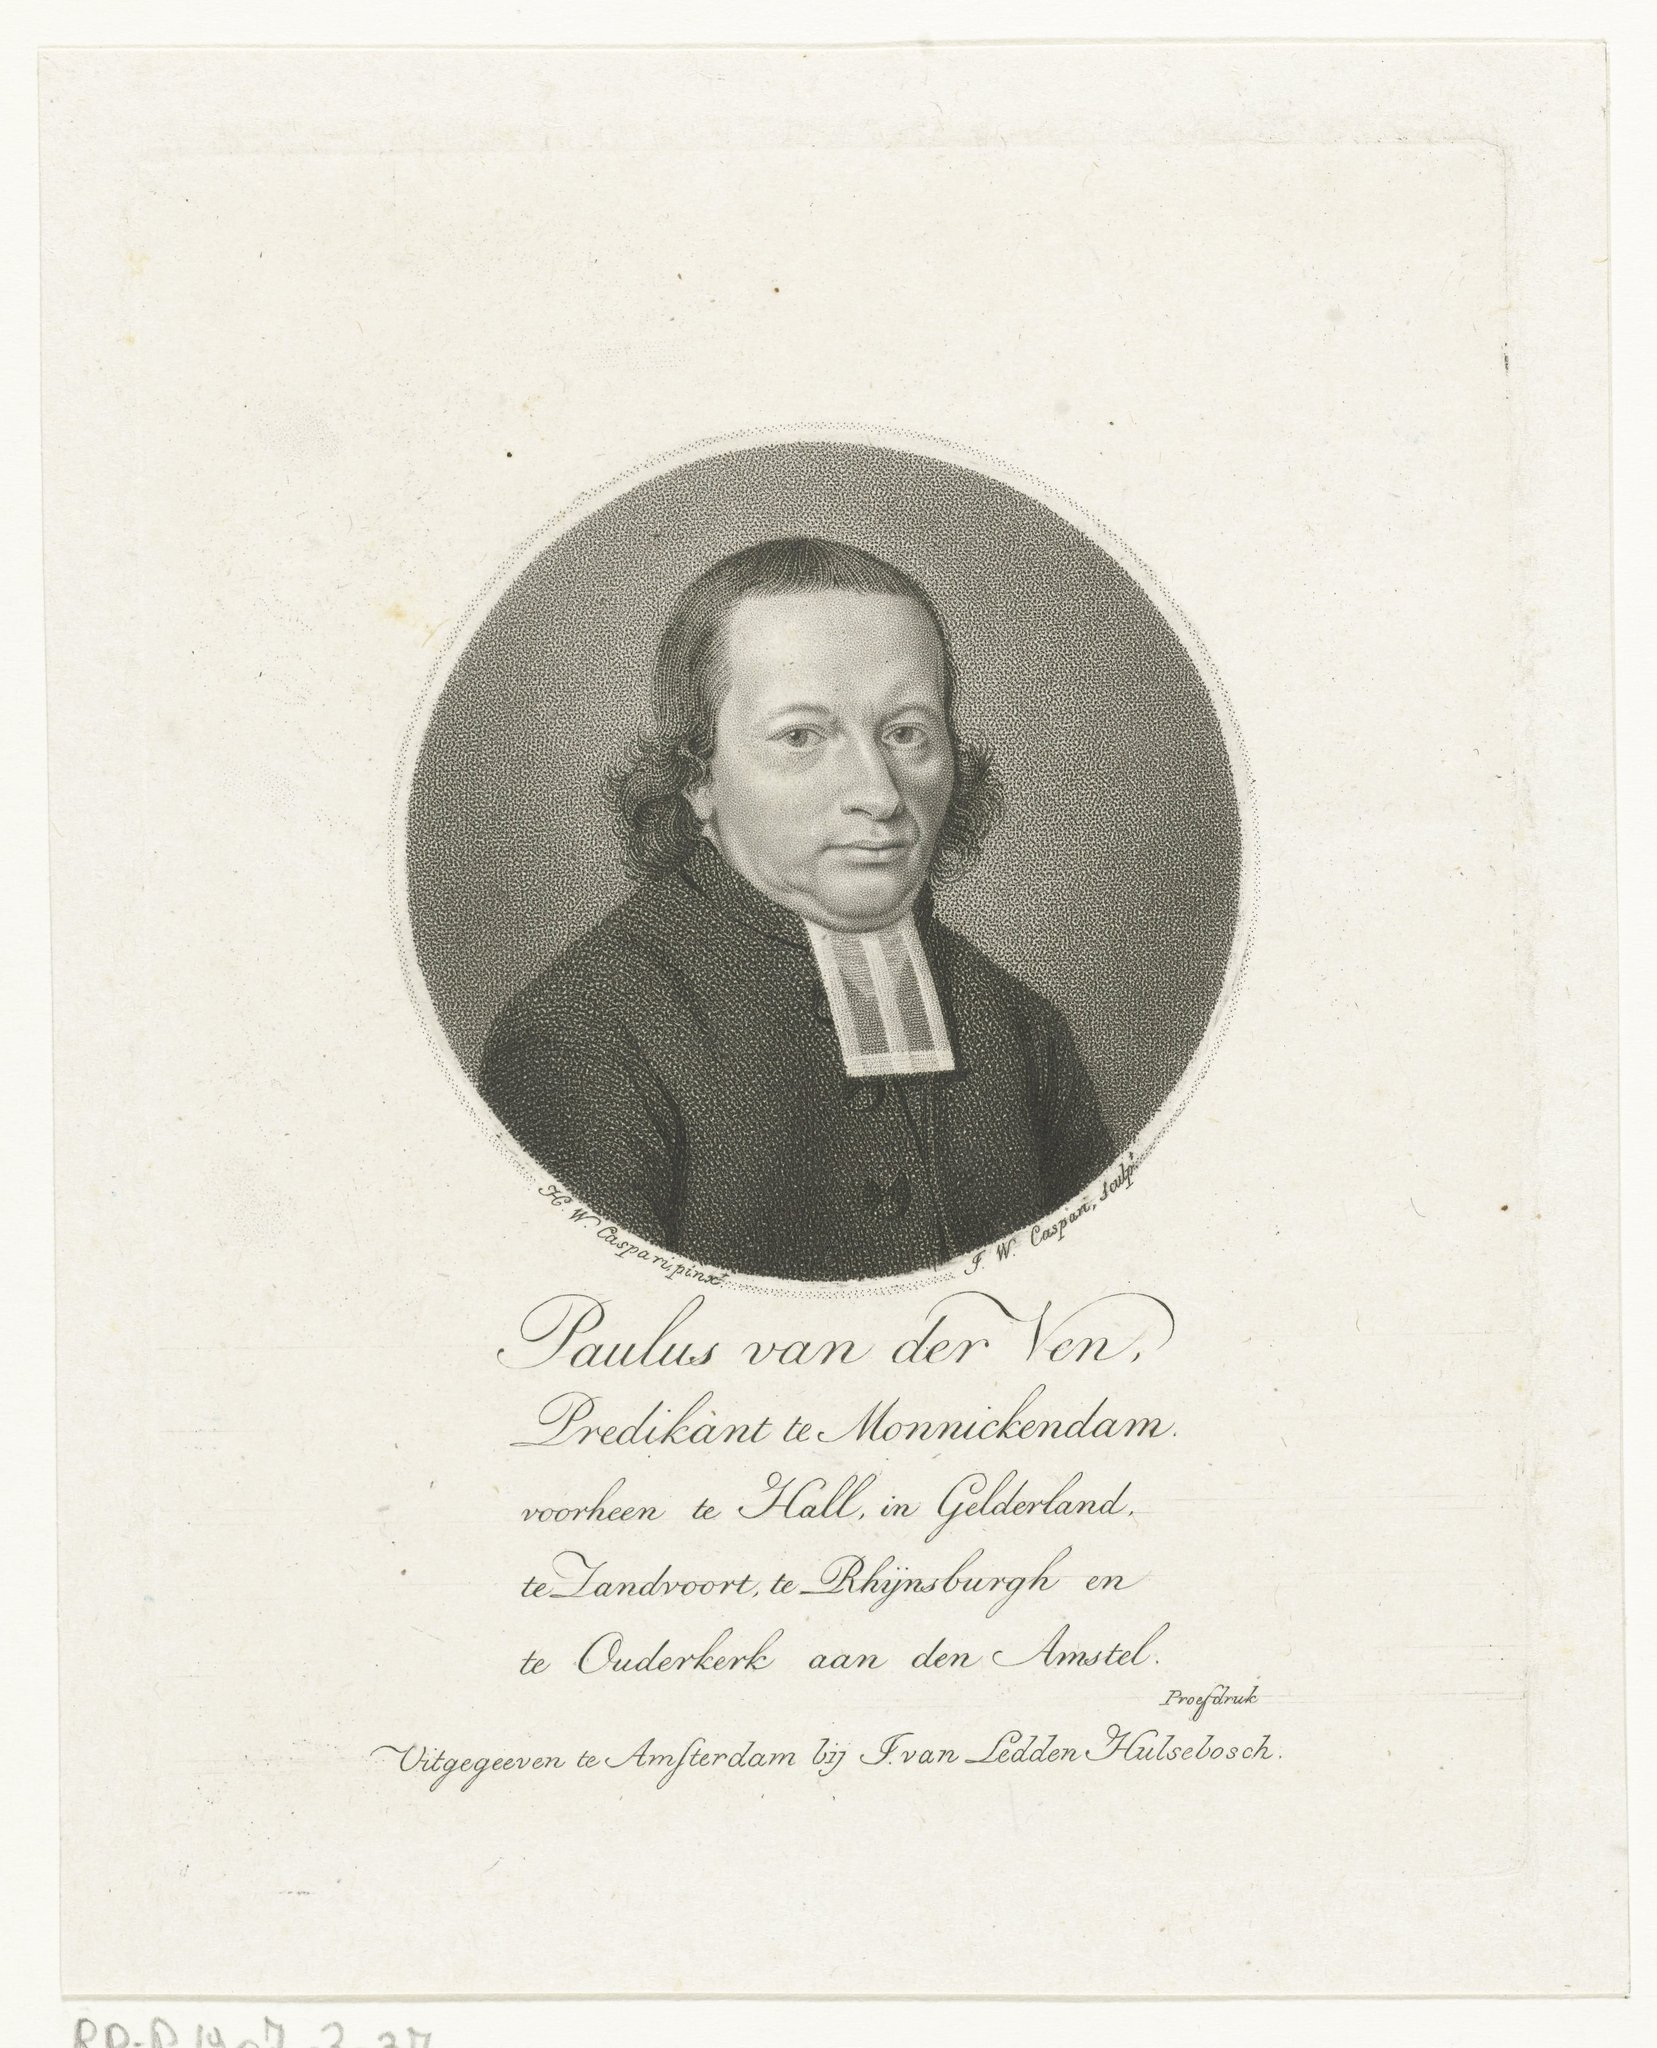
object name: print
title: Portret van Paulus van der Ven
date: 1789-1822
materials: paper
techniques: etching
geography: amsterdam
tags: monnickendam, predikant, paulus van der ven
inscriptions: collector's mark: Lugt 2228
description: Portret in ronde lijst van Paulus van der Ven, predikant te Monnickendam. Buste naar rechts. Van der Ven heeft een zwarte toga aan met een witte bef. De prent heeft een Nederlands onderschrift met de naam van de geportretteerde.